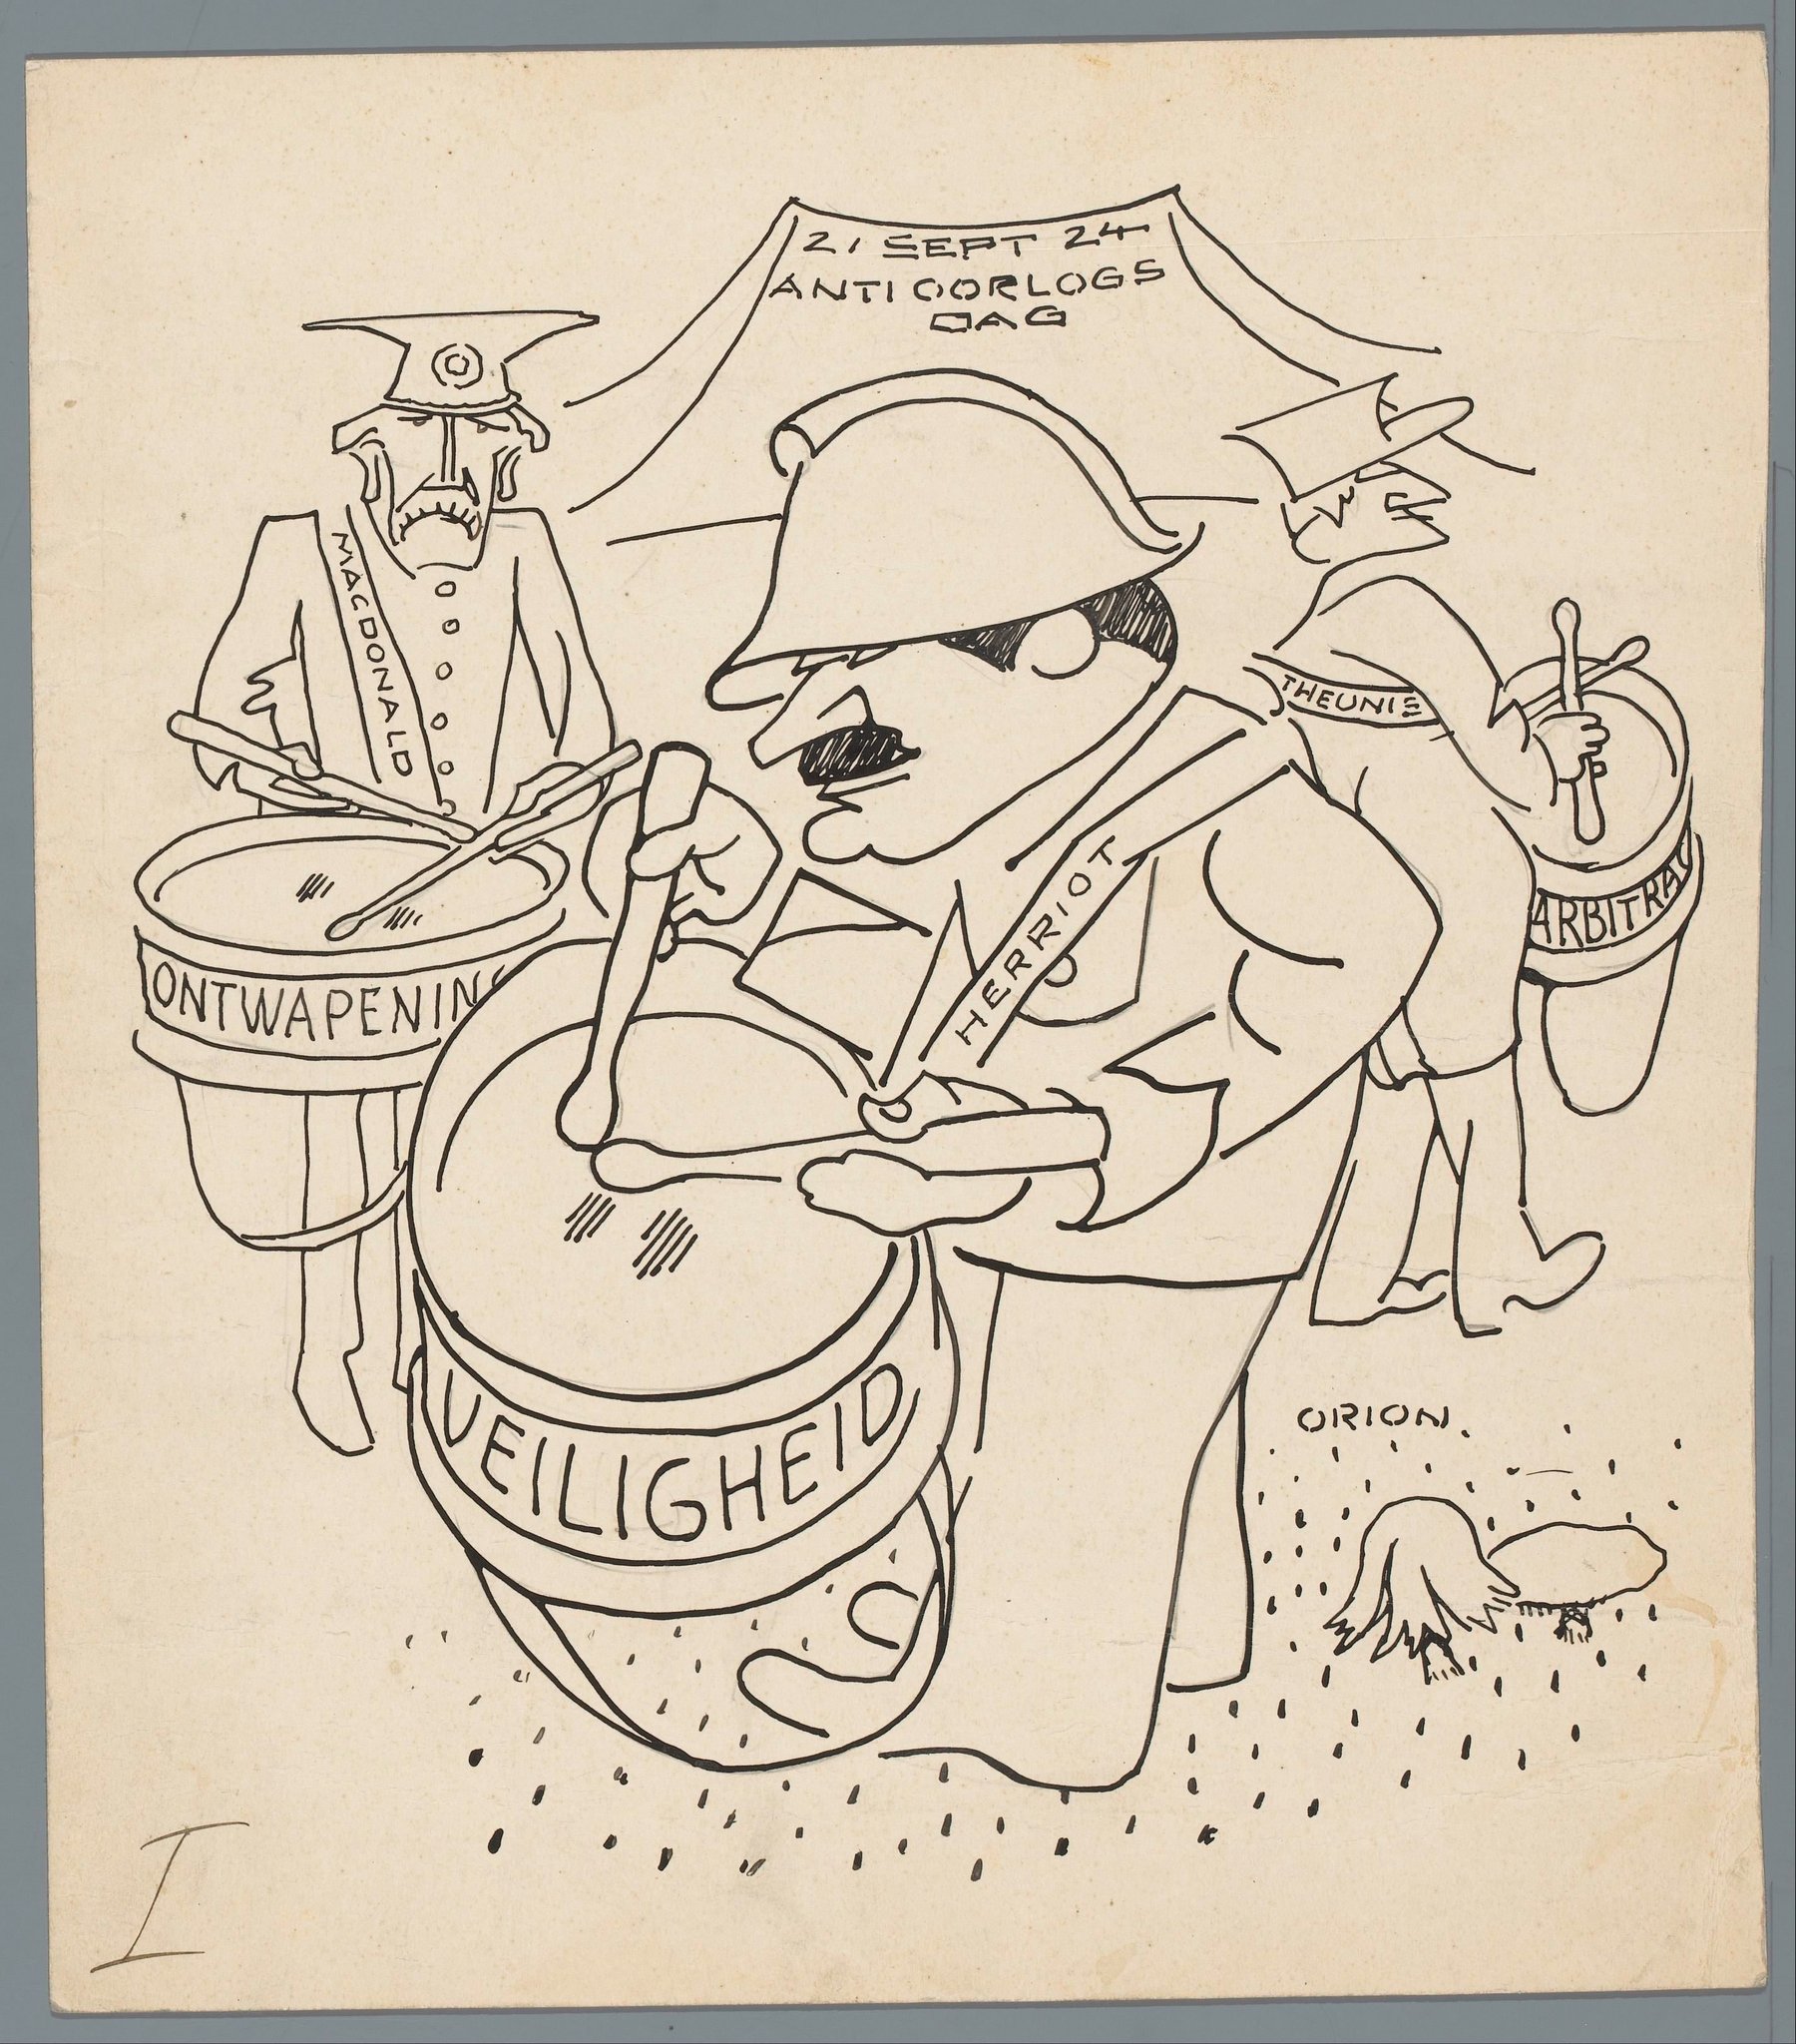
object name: cartoon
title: Antioorlogsdag 1924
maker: patricq kroon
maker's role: draughtsman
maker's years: 1862-1941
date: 1924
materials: ink, paper, pencil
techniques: pen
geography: netherlands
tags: united kingdom, atlantic ocean, anti-militarism, pacifism, political caricatures and satires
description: MacDonald, Herriot en Theunis, de premiers van Groot-Brittannië, Frankrijk en België, slaan op trommels in een legerkamp op 12 september 1924. Ontwerp voor een politieke spotprent.